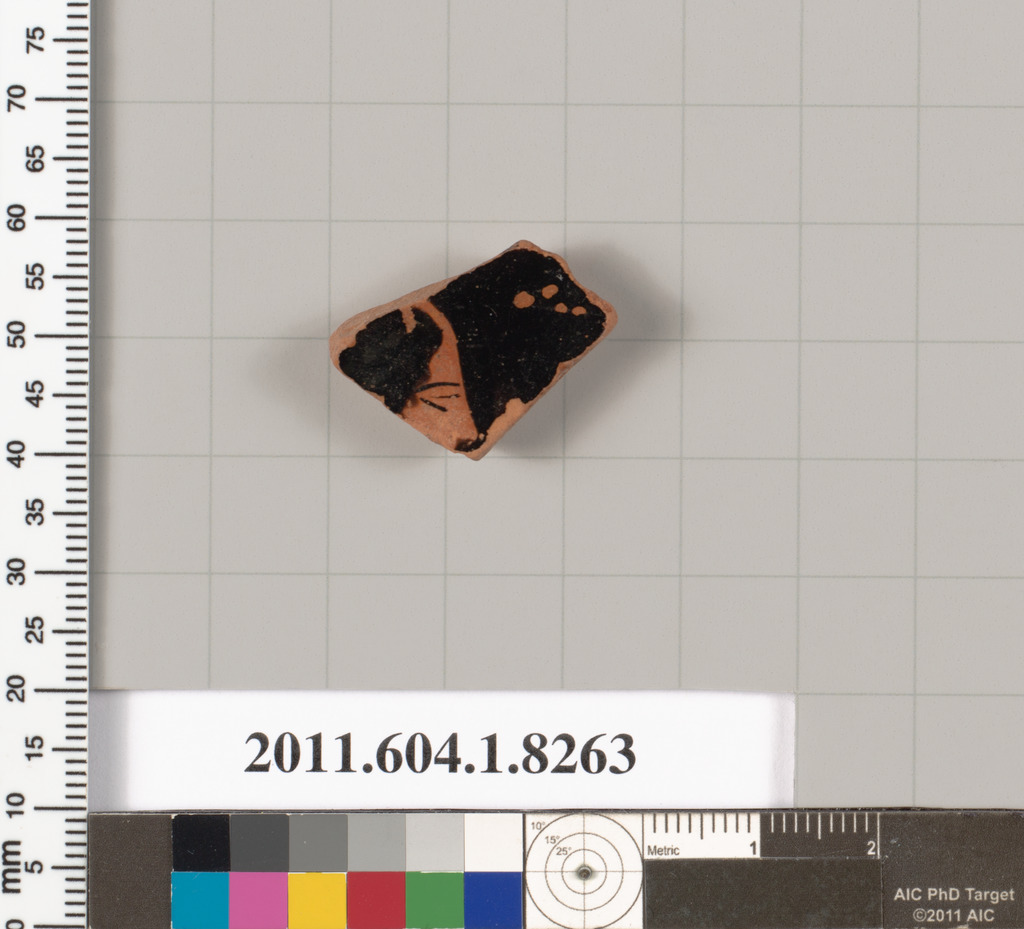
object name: kylix fragment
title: Terracotta fragment of a kylix (drinking cup)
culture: greek, attic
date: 410-400 BCE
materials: terracotta